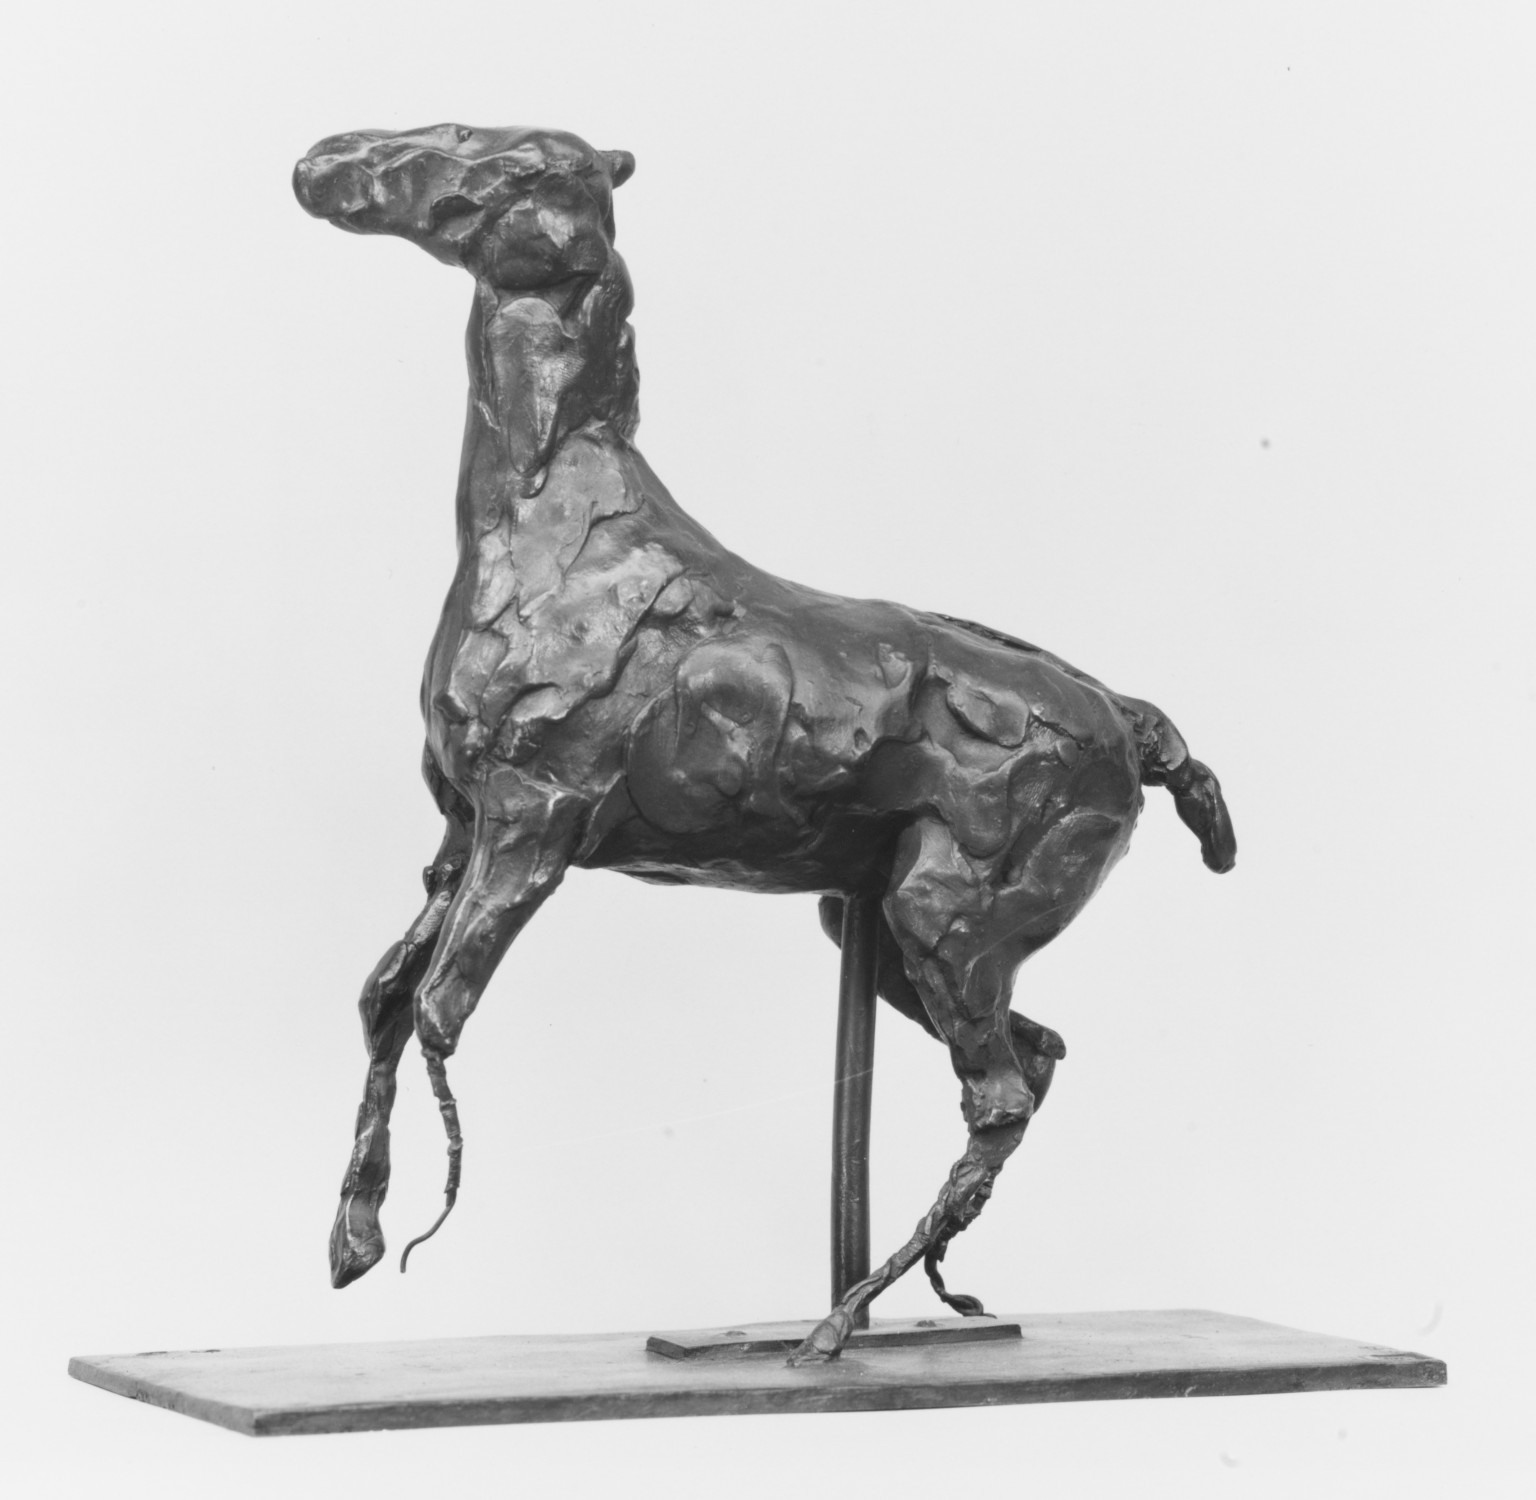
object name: statuette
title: Prancing Horse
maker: edgar degas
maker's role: artist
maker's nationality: french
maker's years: 1834-1917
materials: bronze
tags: horses